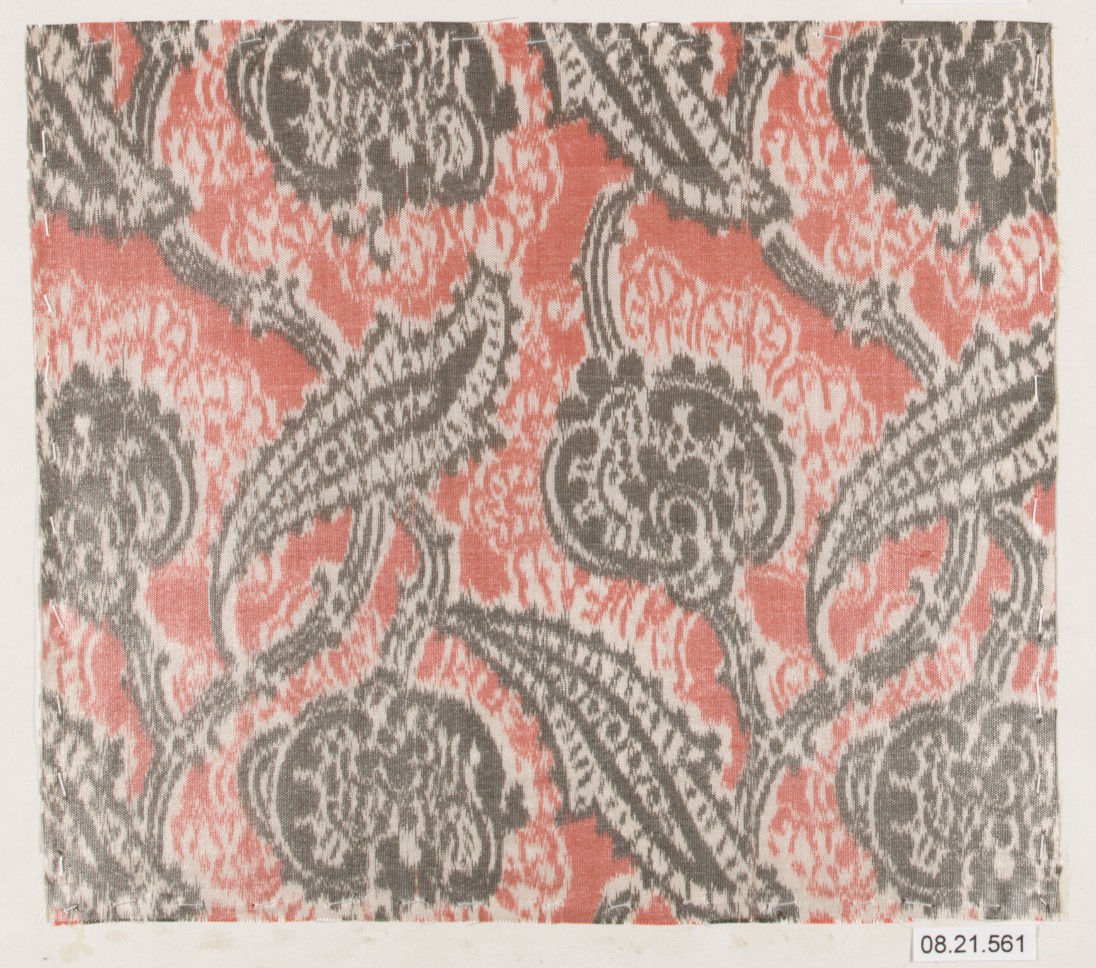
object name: textile sample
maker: Anonymous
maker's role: designer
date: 1900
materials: silk